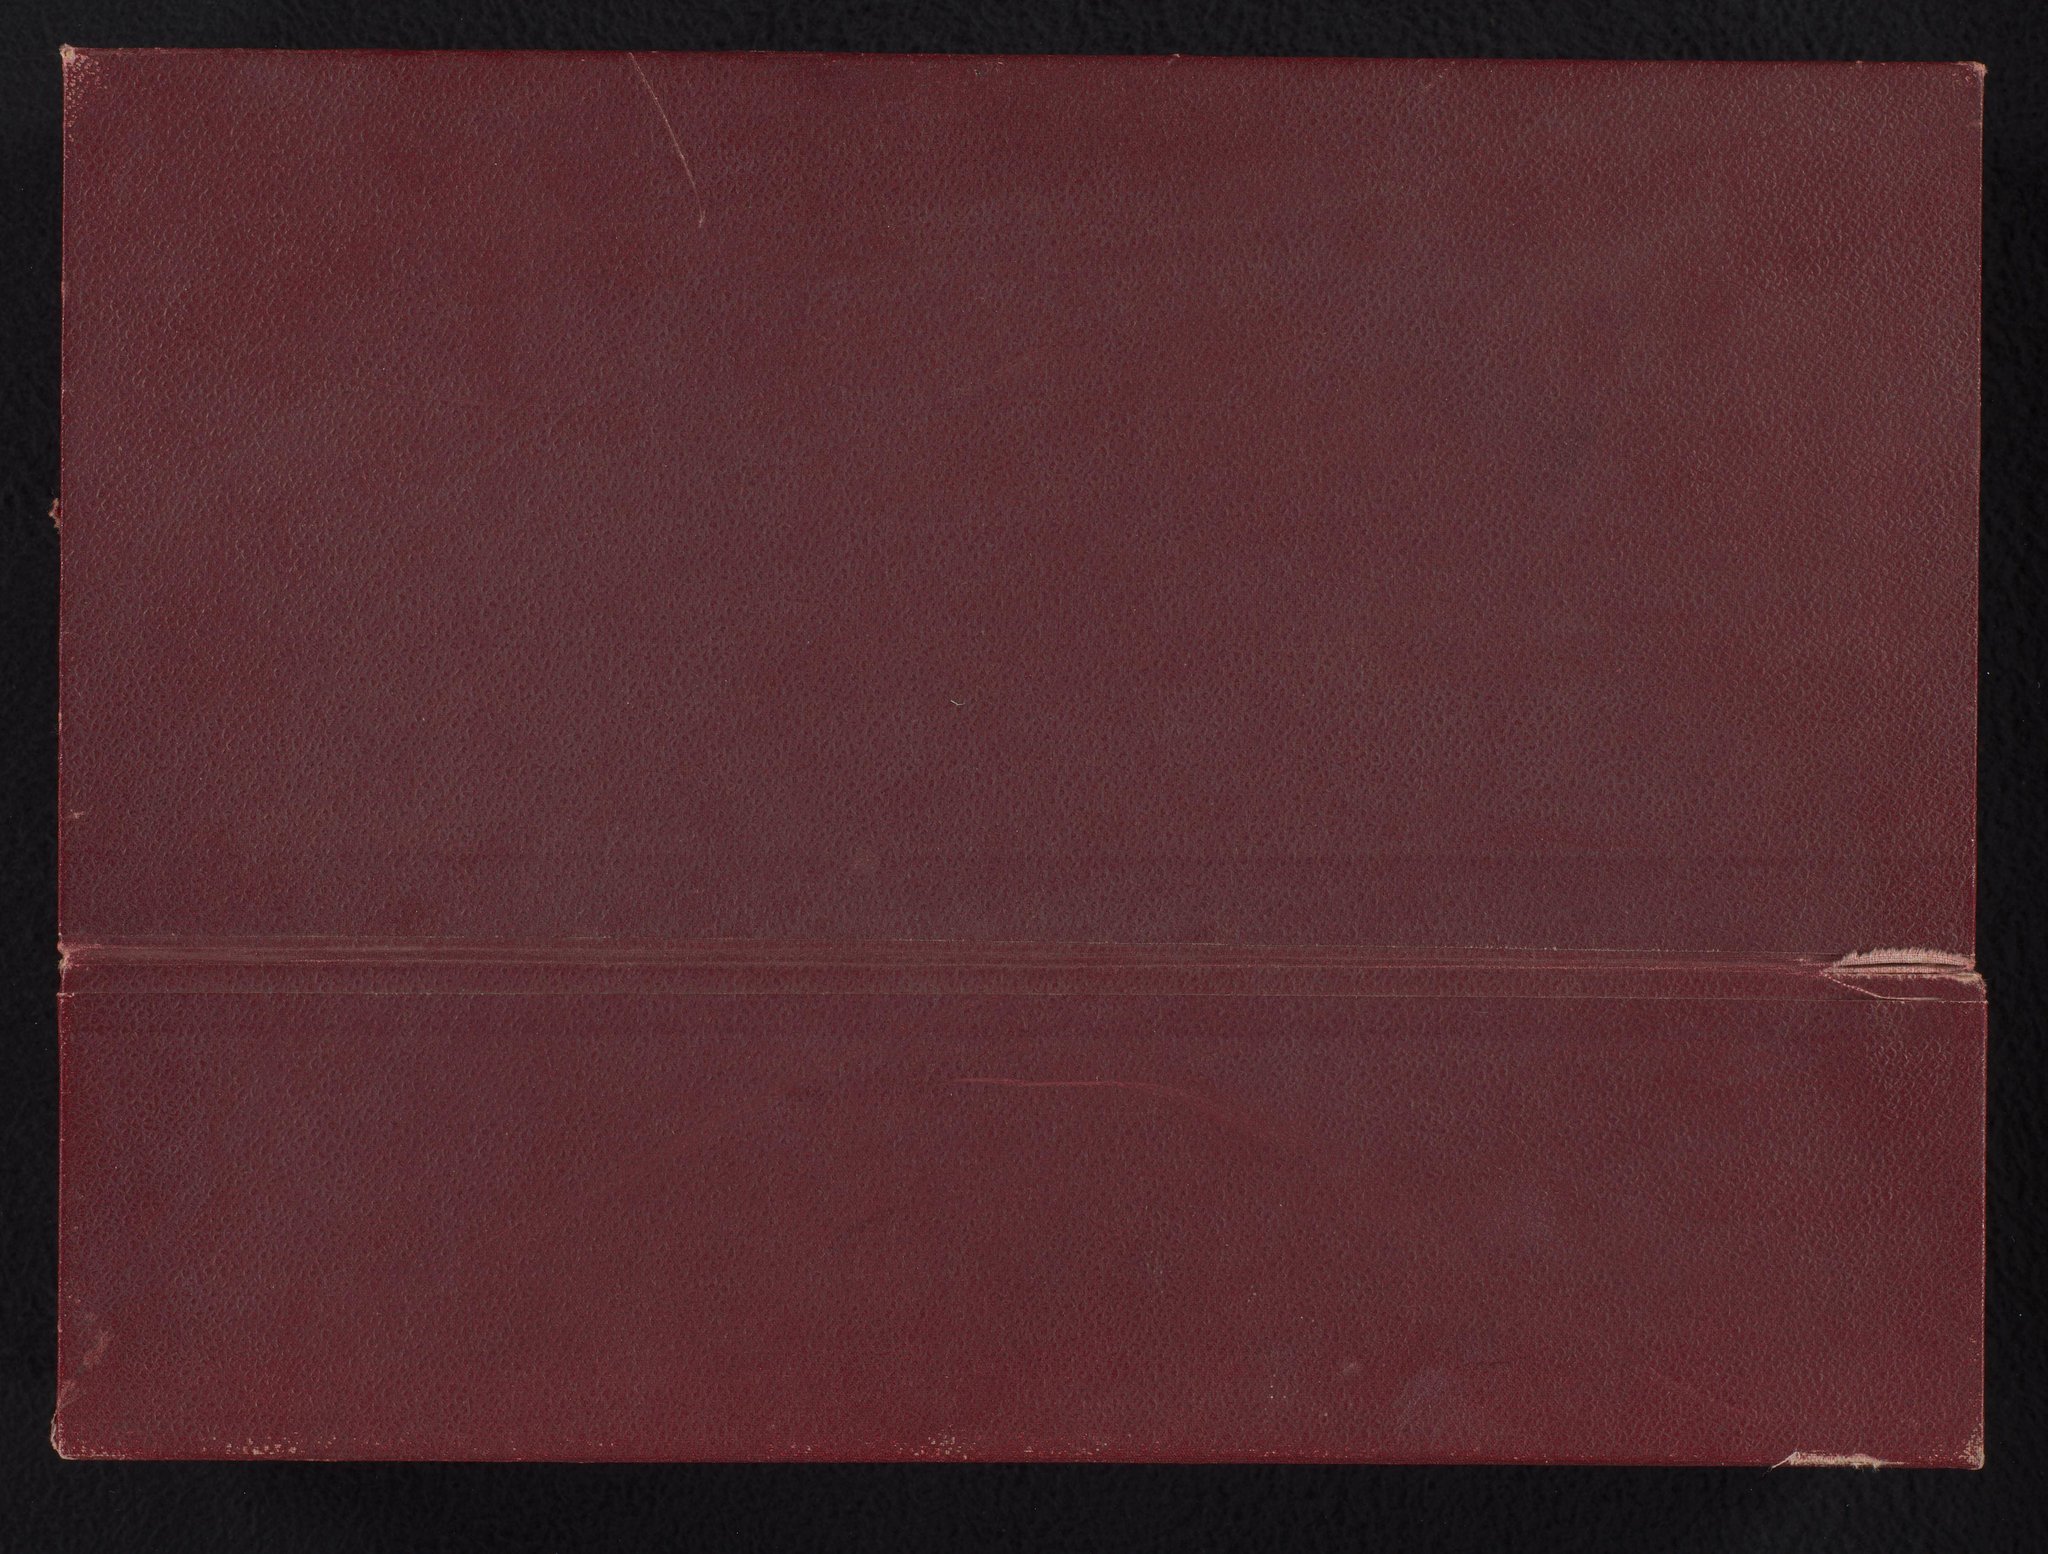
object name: wrapper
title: Nederlands-Indië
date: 1895-1915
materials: cardboard, leather, linen, paper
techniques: decorated paper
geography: dutch east indies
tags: temple, shrine ~ hinduism, buddhism, jainism, landscapes, historical persons, piece of sculpture, reproduction of a piece of sculpture, dutch east indies, the